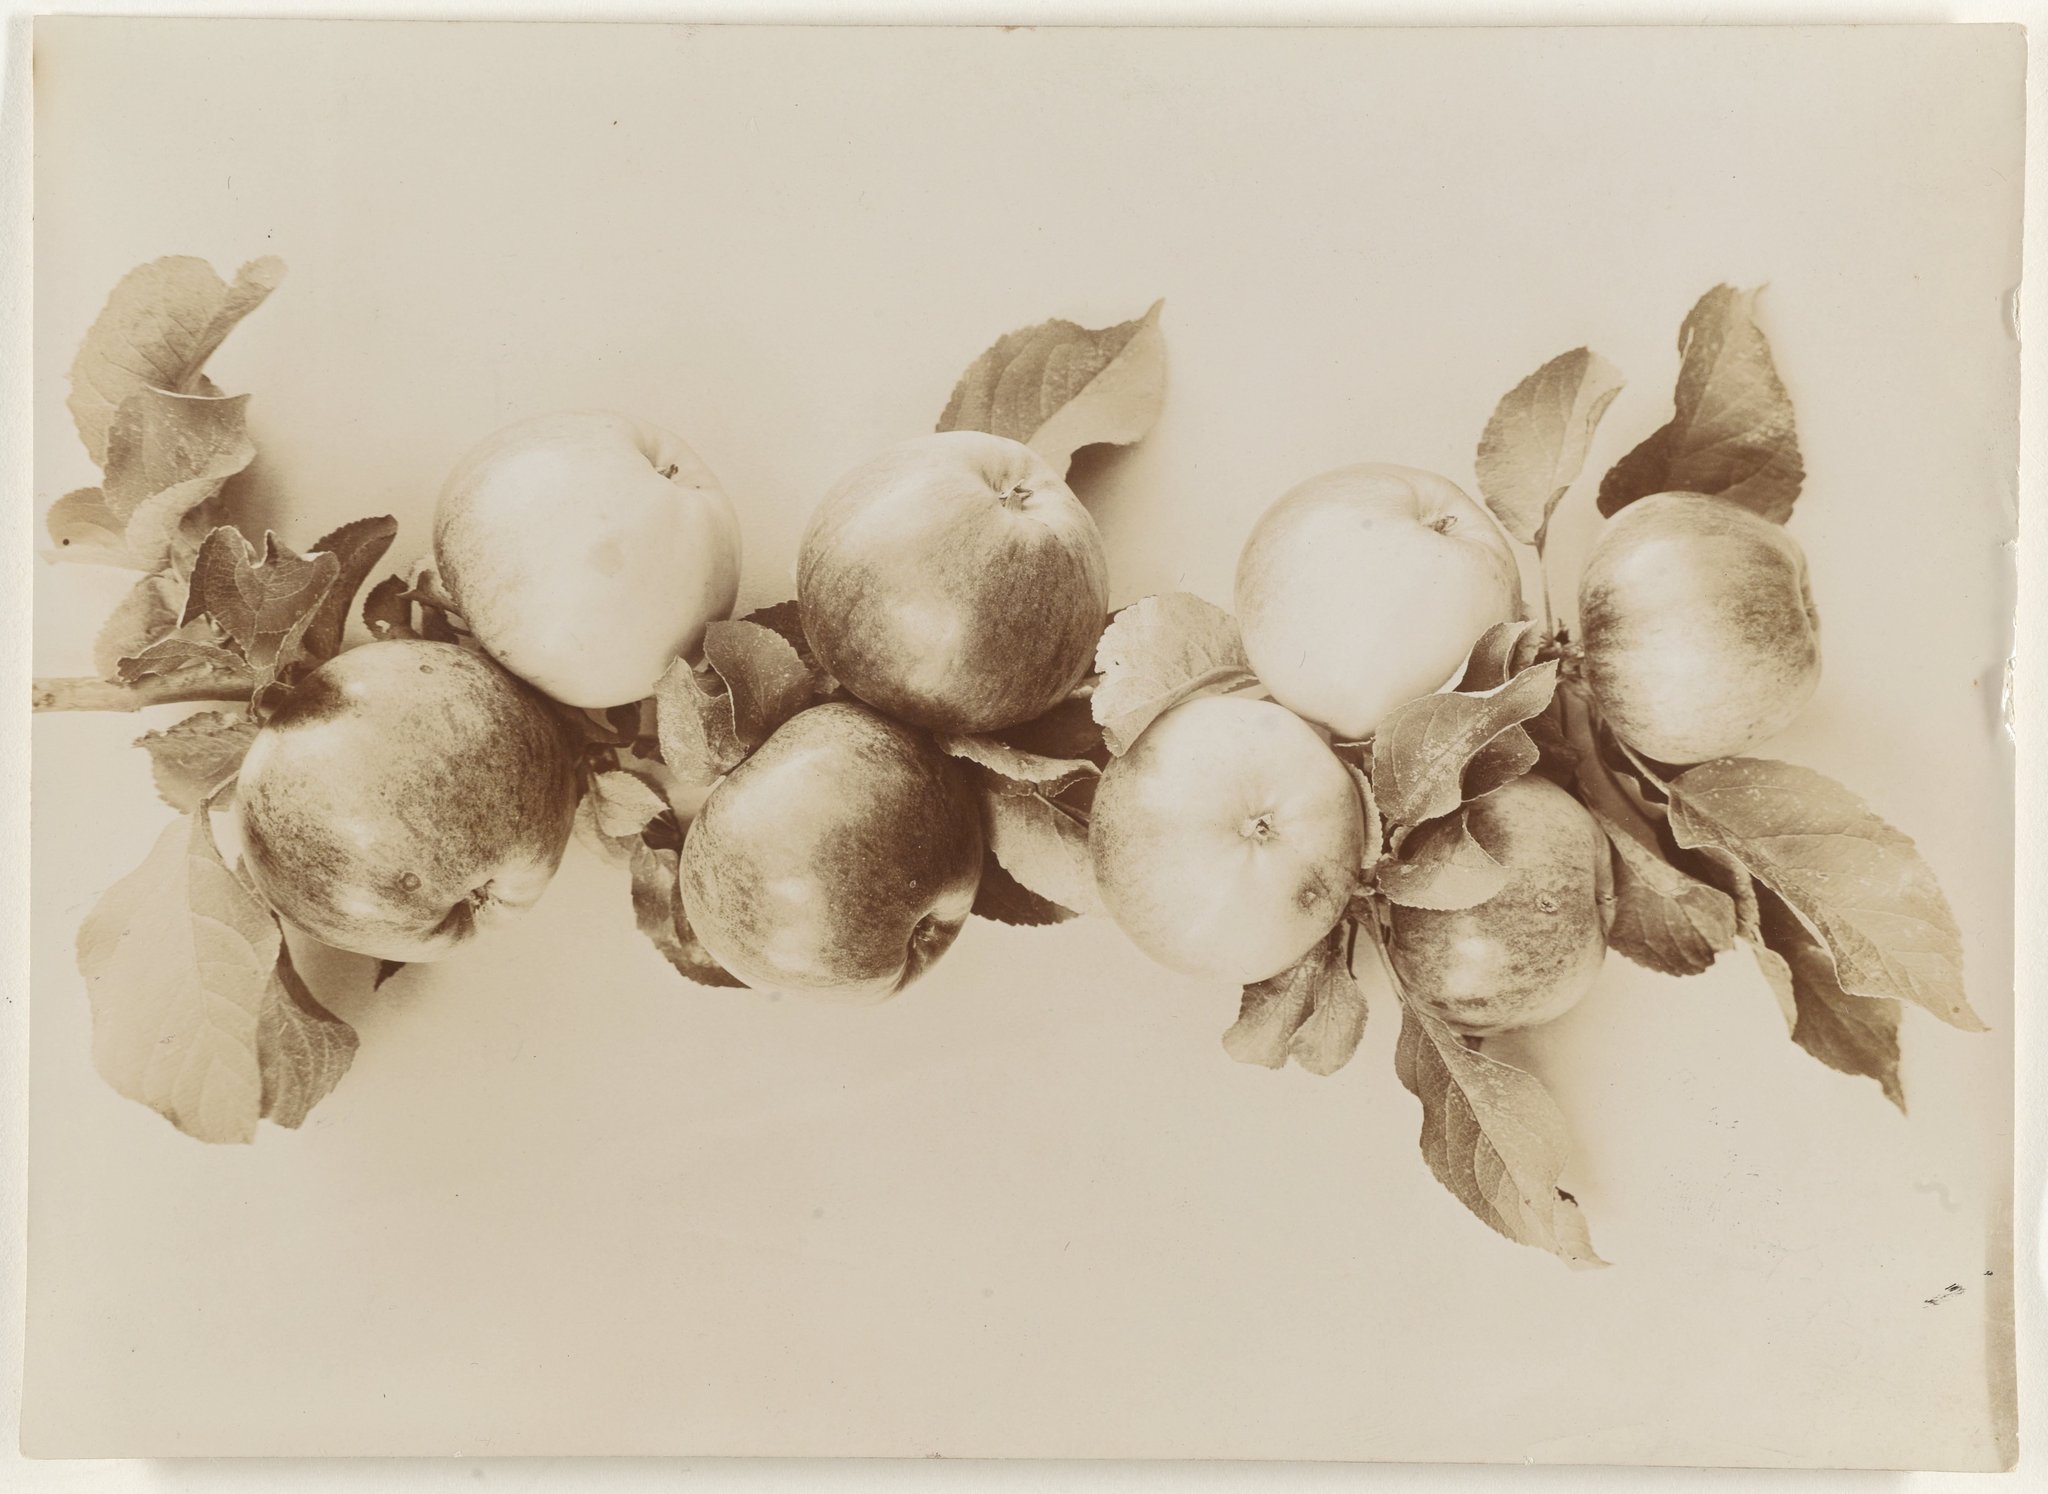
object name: photograph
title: Tak met appels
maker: richard tepe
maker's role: fotograaf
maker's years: 1864-1952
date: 1900-1930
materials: photographic support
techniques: gelatin silver print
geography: netherlands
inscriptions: annotation: ‘bovenzyde / Bismarck Appel / vruchtdragende tak / kolombreedte’, signature: ‘foto / R Tepe’